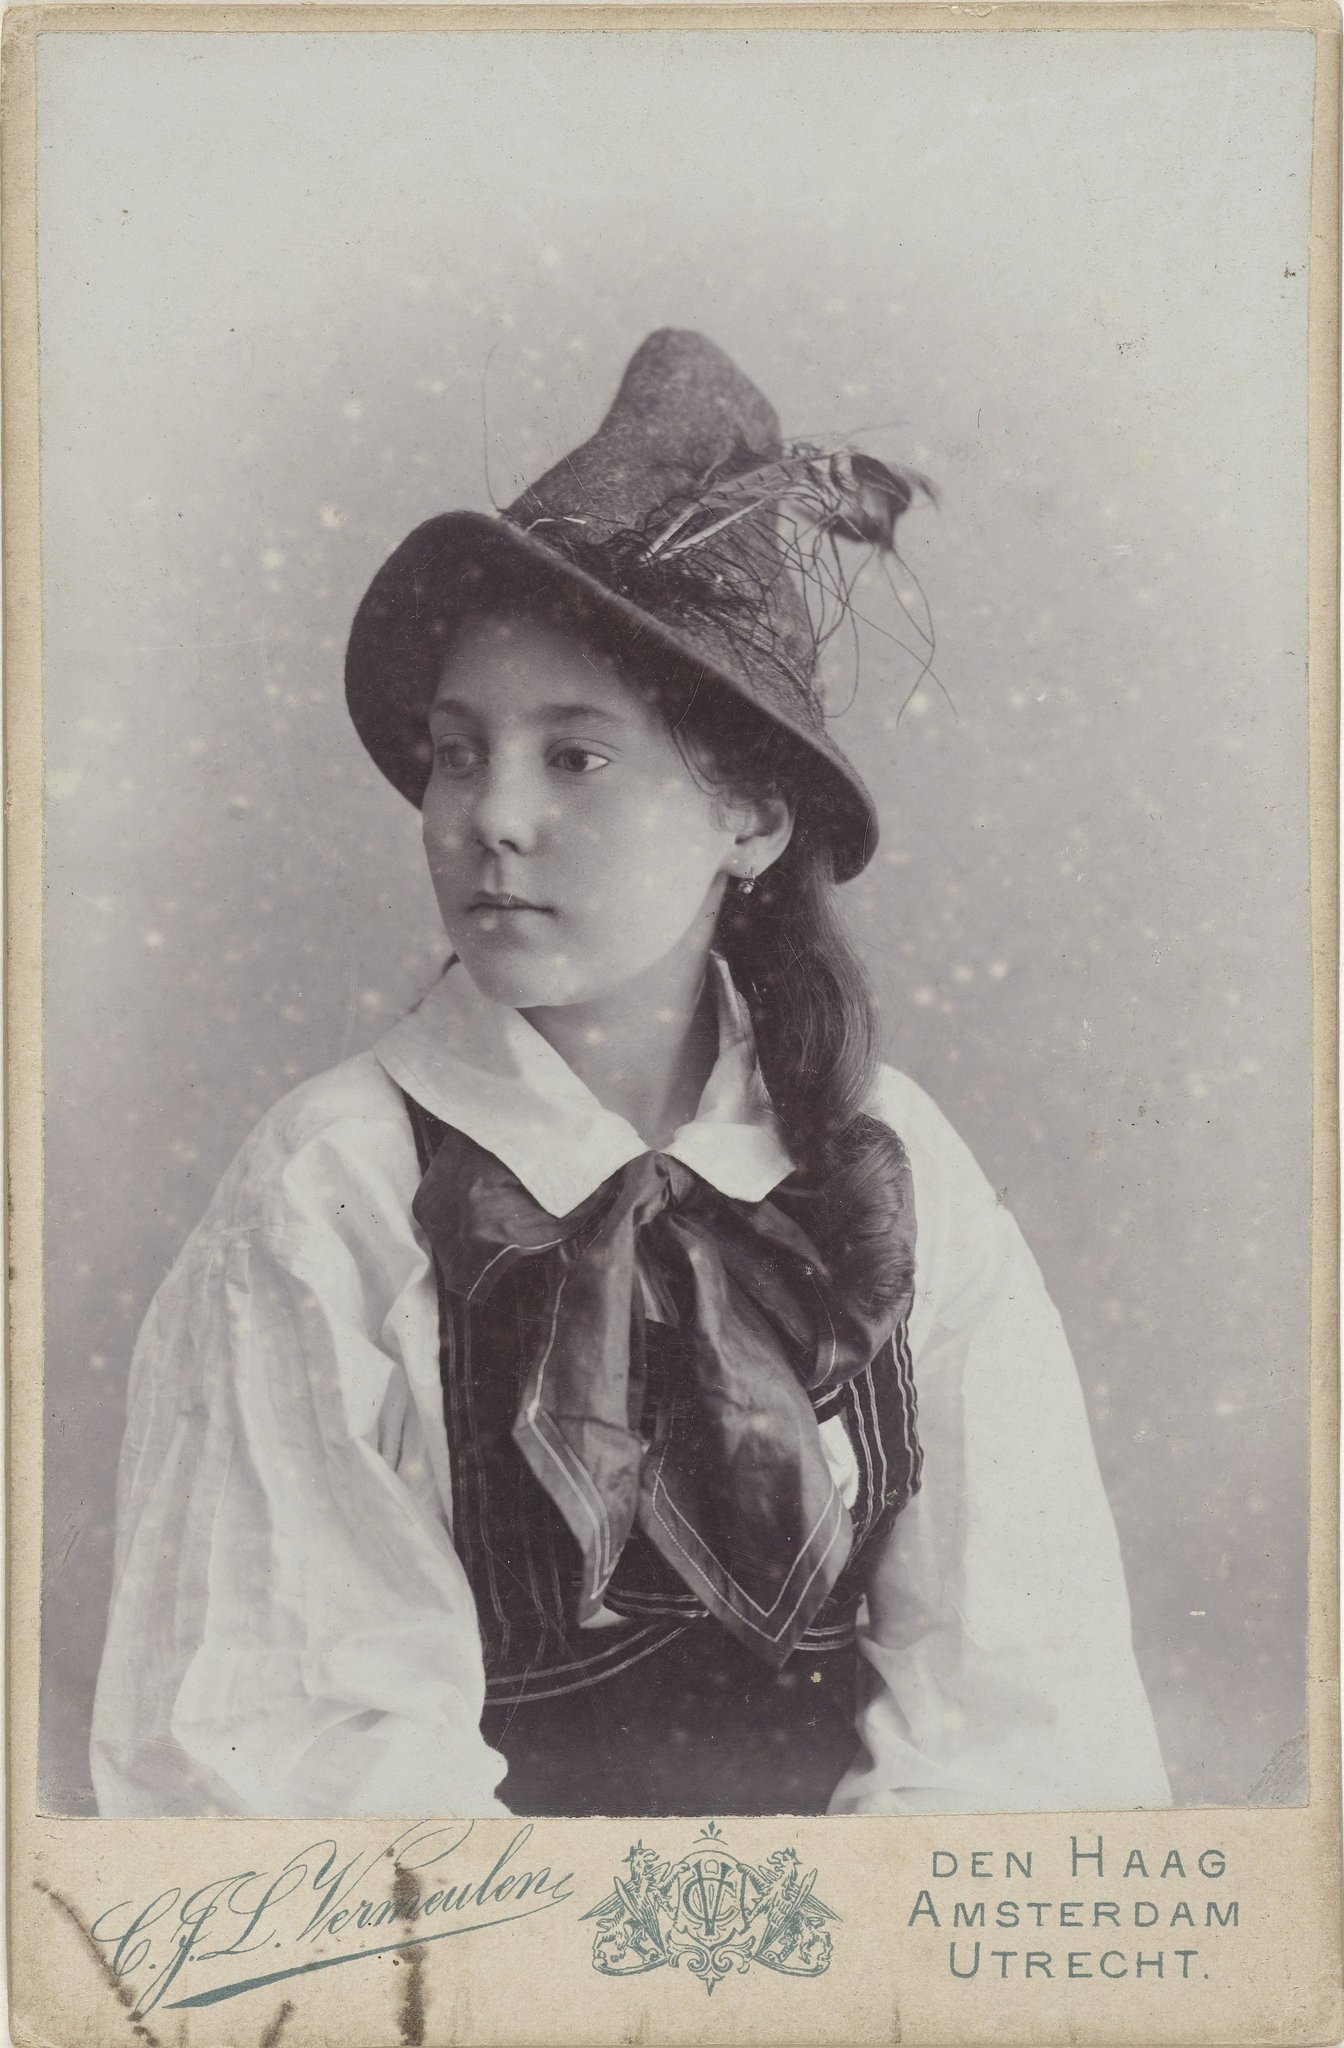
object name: photograph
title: Grietje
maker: cornelis johannes lodewicus vermeulen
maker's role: fotograaf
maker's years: 1861-1936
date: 1880-1920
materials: cardboard, photographic support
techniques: albumen print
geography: the hague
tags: netherlands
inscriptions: name: ‘C.J.L. Vermeulen Amsterdam Heiligenweg hoek Singel’